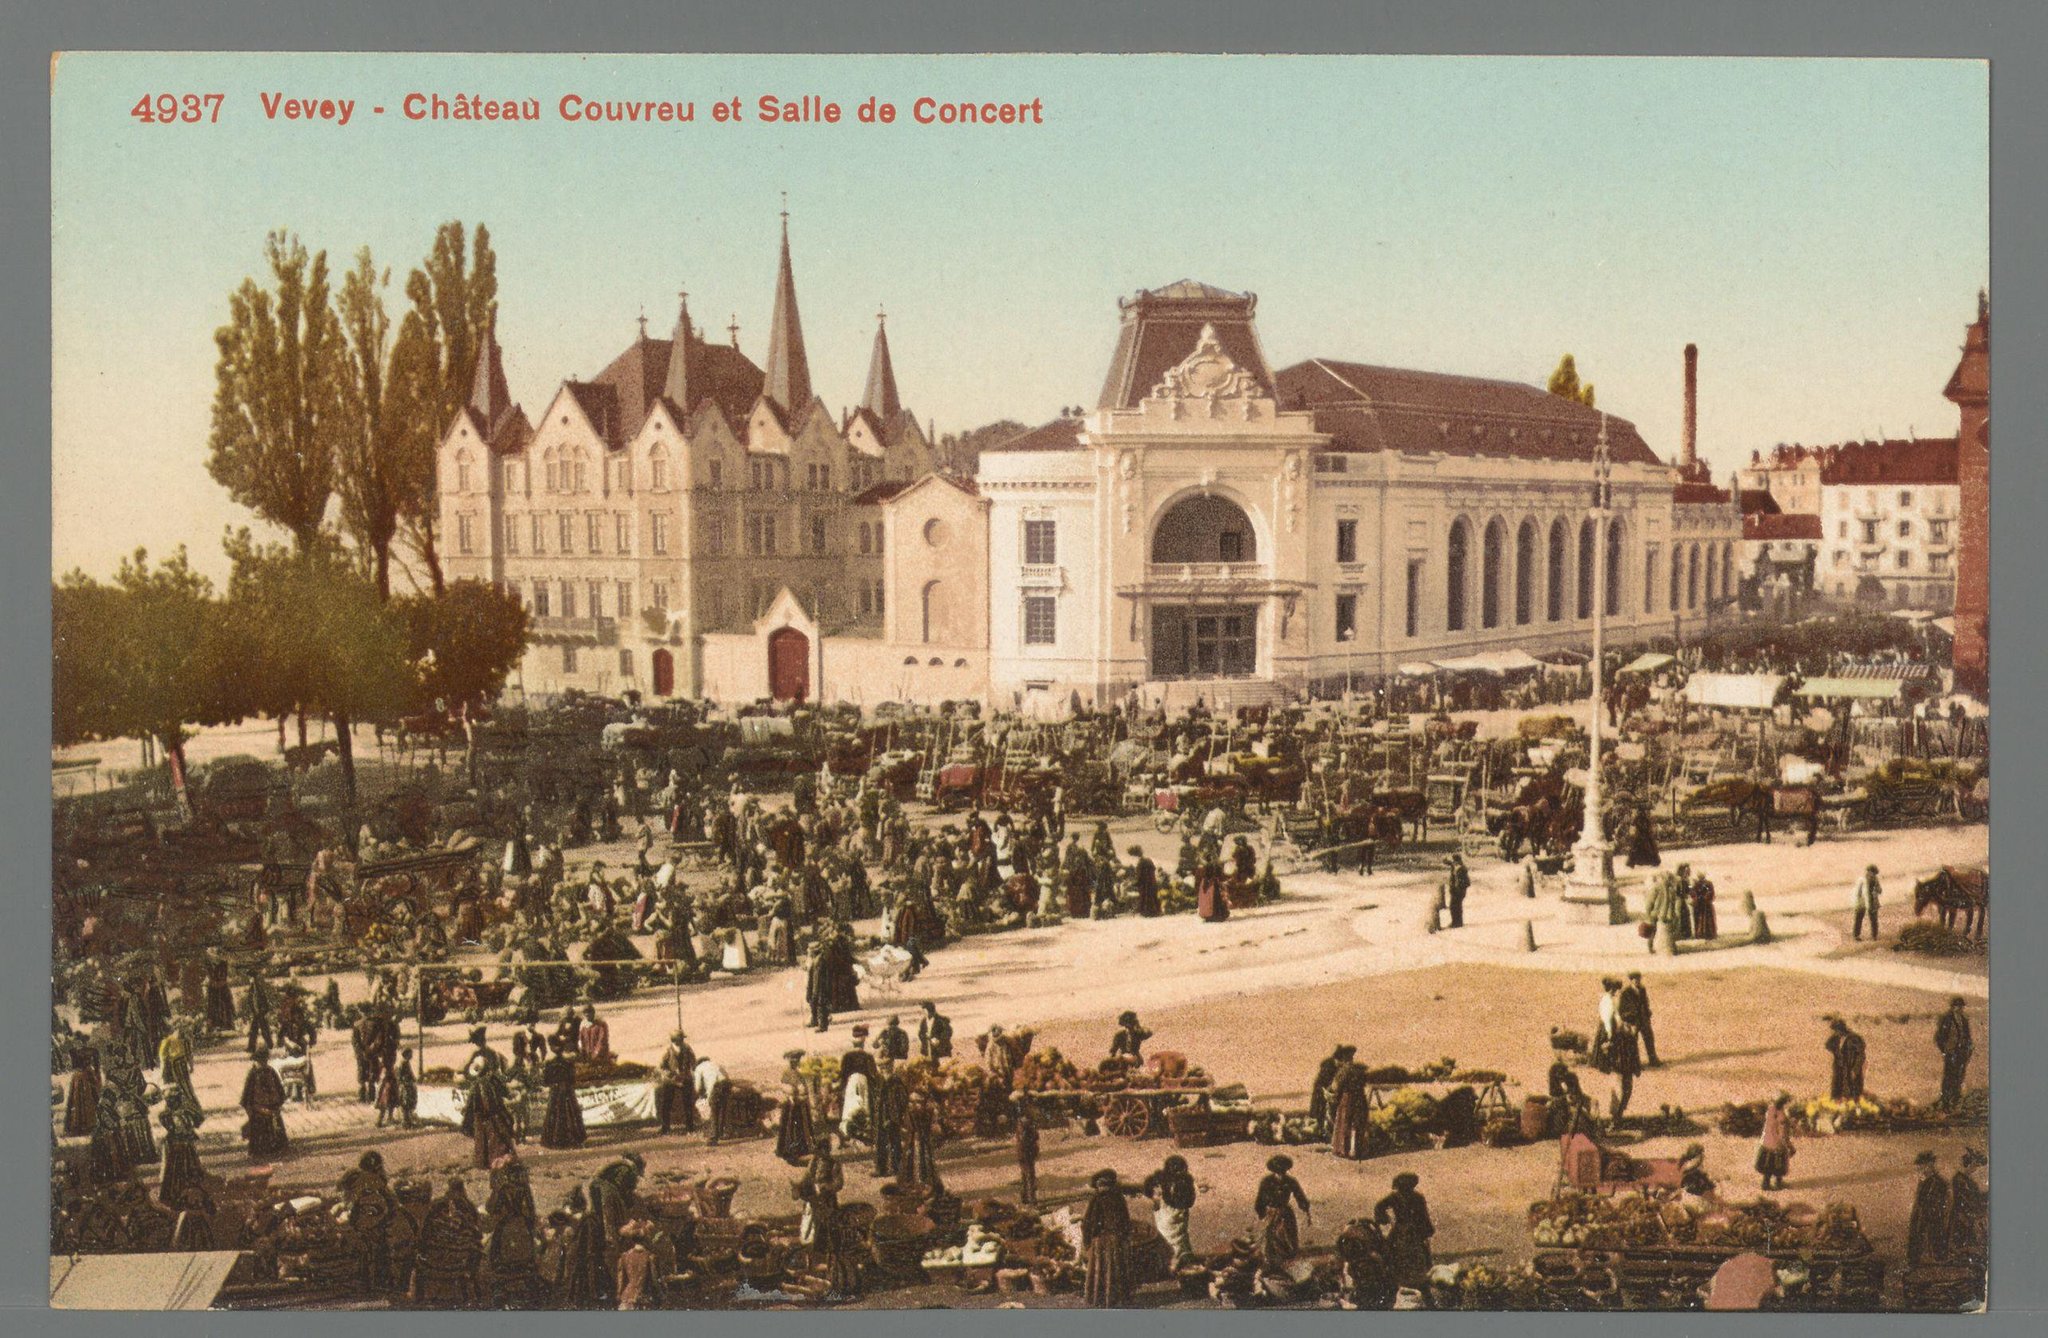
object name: ansichtkaart, prentbriefkaart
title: Vevey. Château Couvreu et Salle de Concert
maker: Anonymous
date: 1905-1920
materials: cardboard, photographic process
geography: zurich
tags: palace, square, place, circus, etc. (+ city(-scape) with figures, staffage)